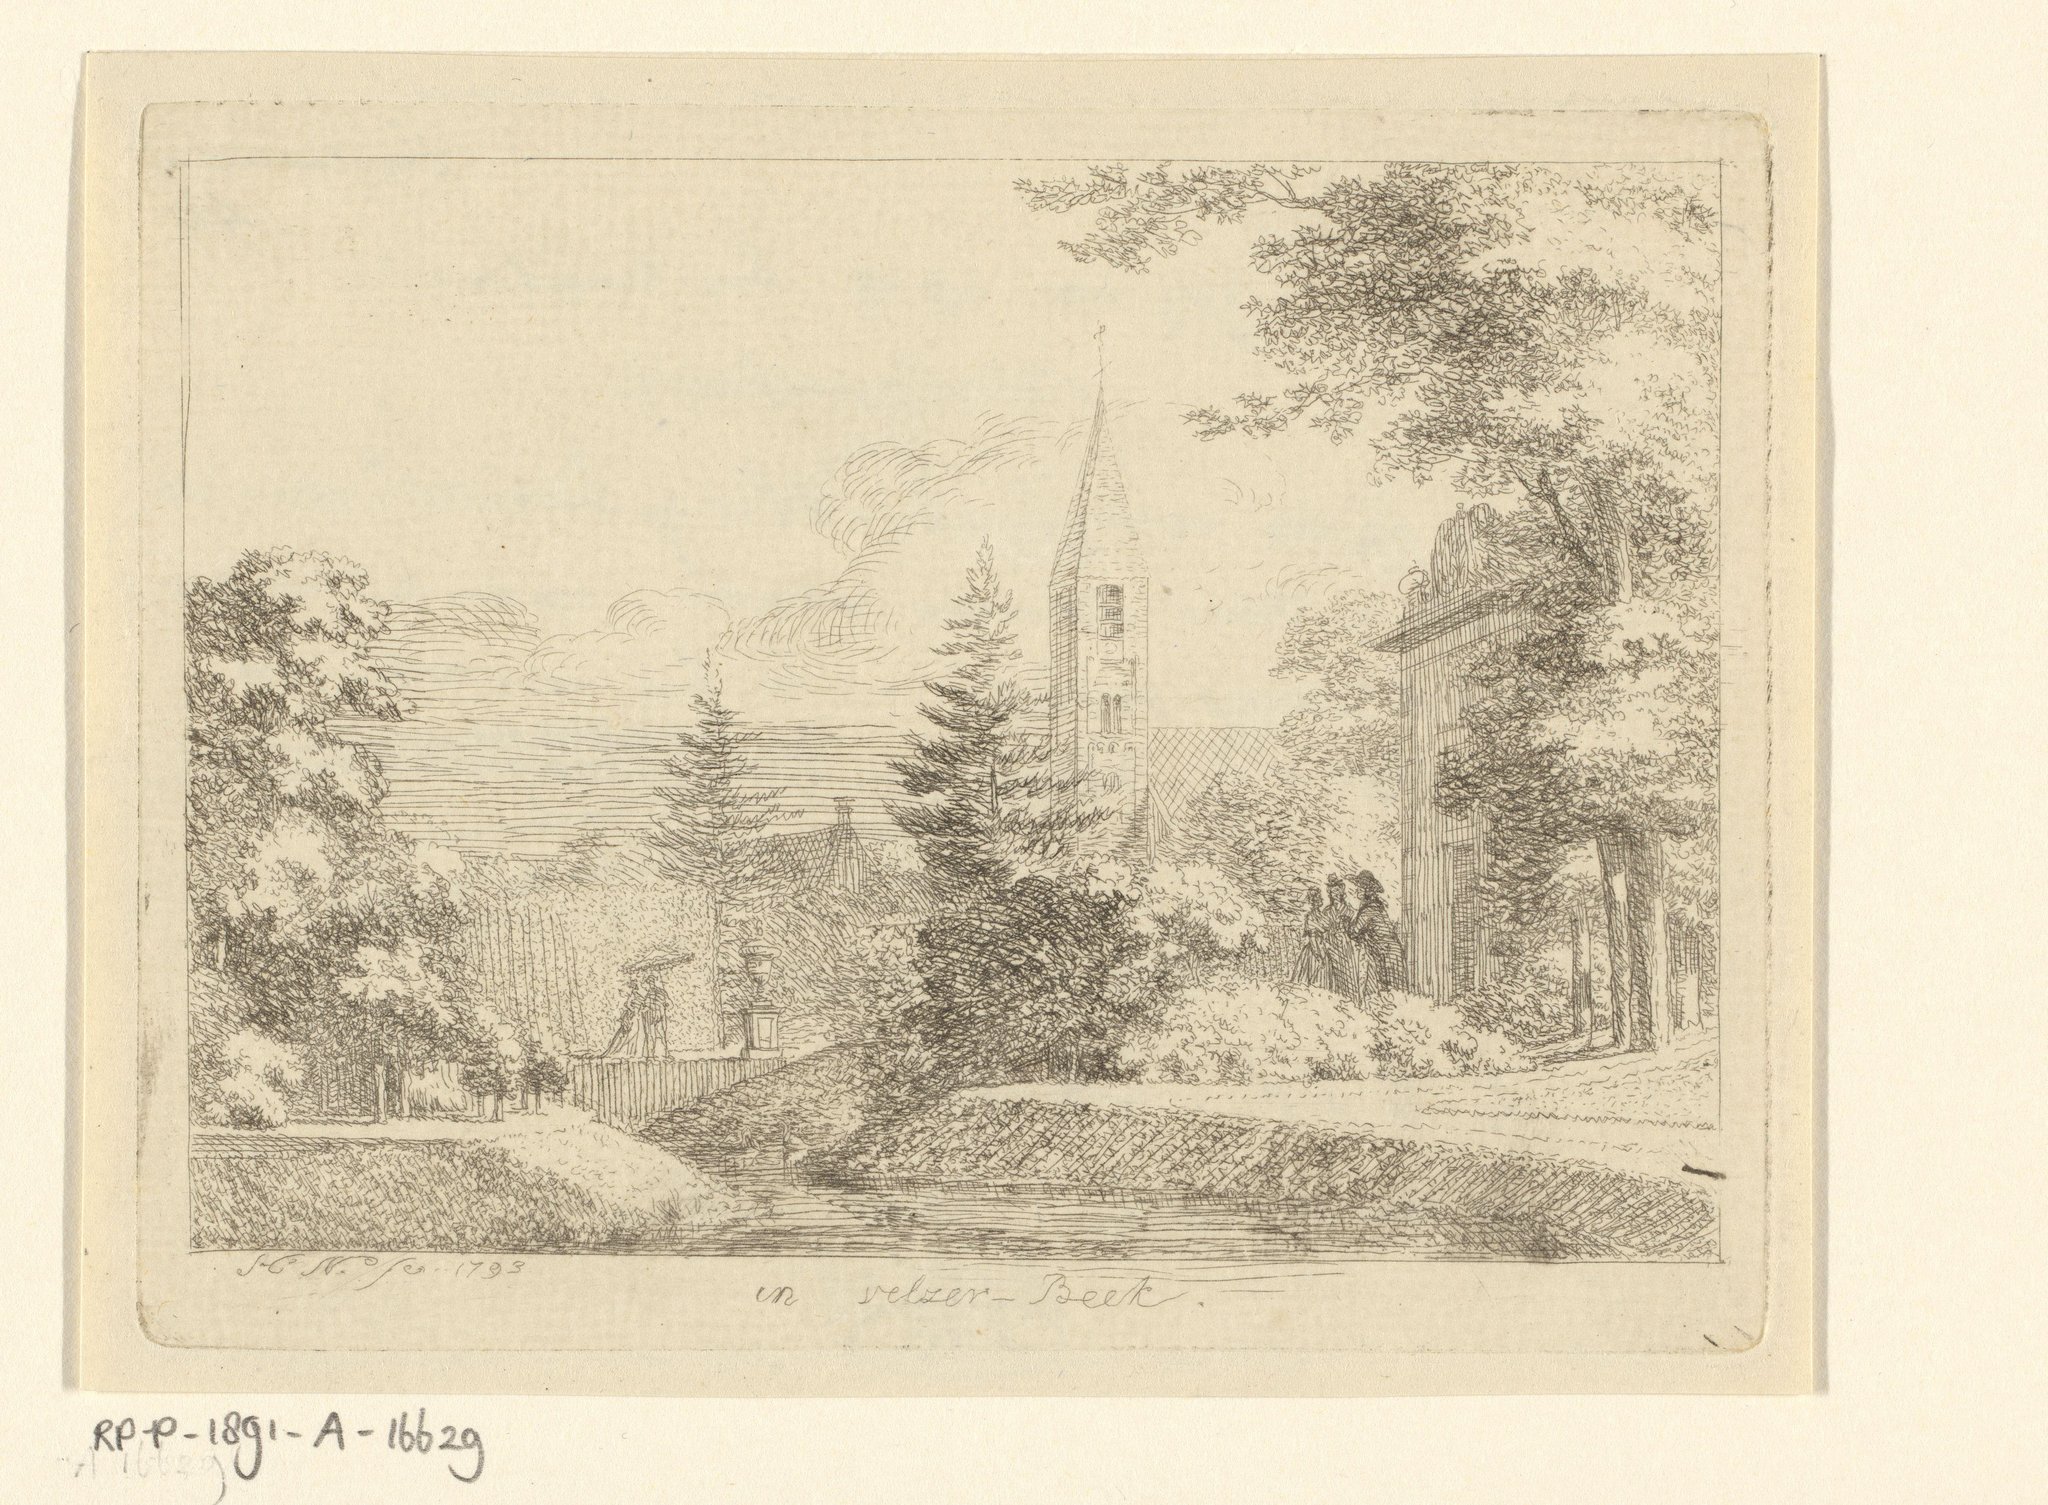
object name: print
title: In Velzer-Beek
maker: hermanus numan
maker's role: draughtsman, painter, print maker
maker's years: 1744-1820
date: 1793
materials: paper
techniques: etching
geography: netherlands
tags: country-house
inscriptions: collector's mark: Lugt 2228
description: Gezicht op de buitenplaats Velserbeek te Velsen. Rechts op de voorgrond het landhuis, waarvoor een man en twee vrouwen staan. Op de achtergrond een kerk met toren. In het midden staan een man en een vrouw gearmd onder een parasol.